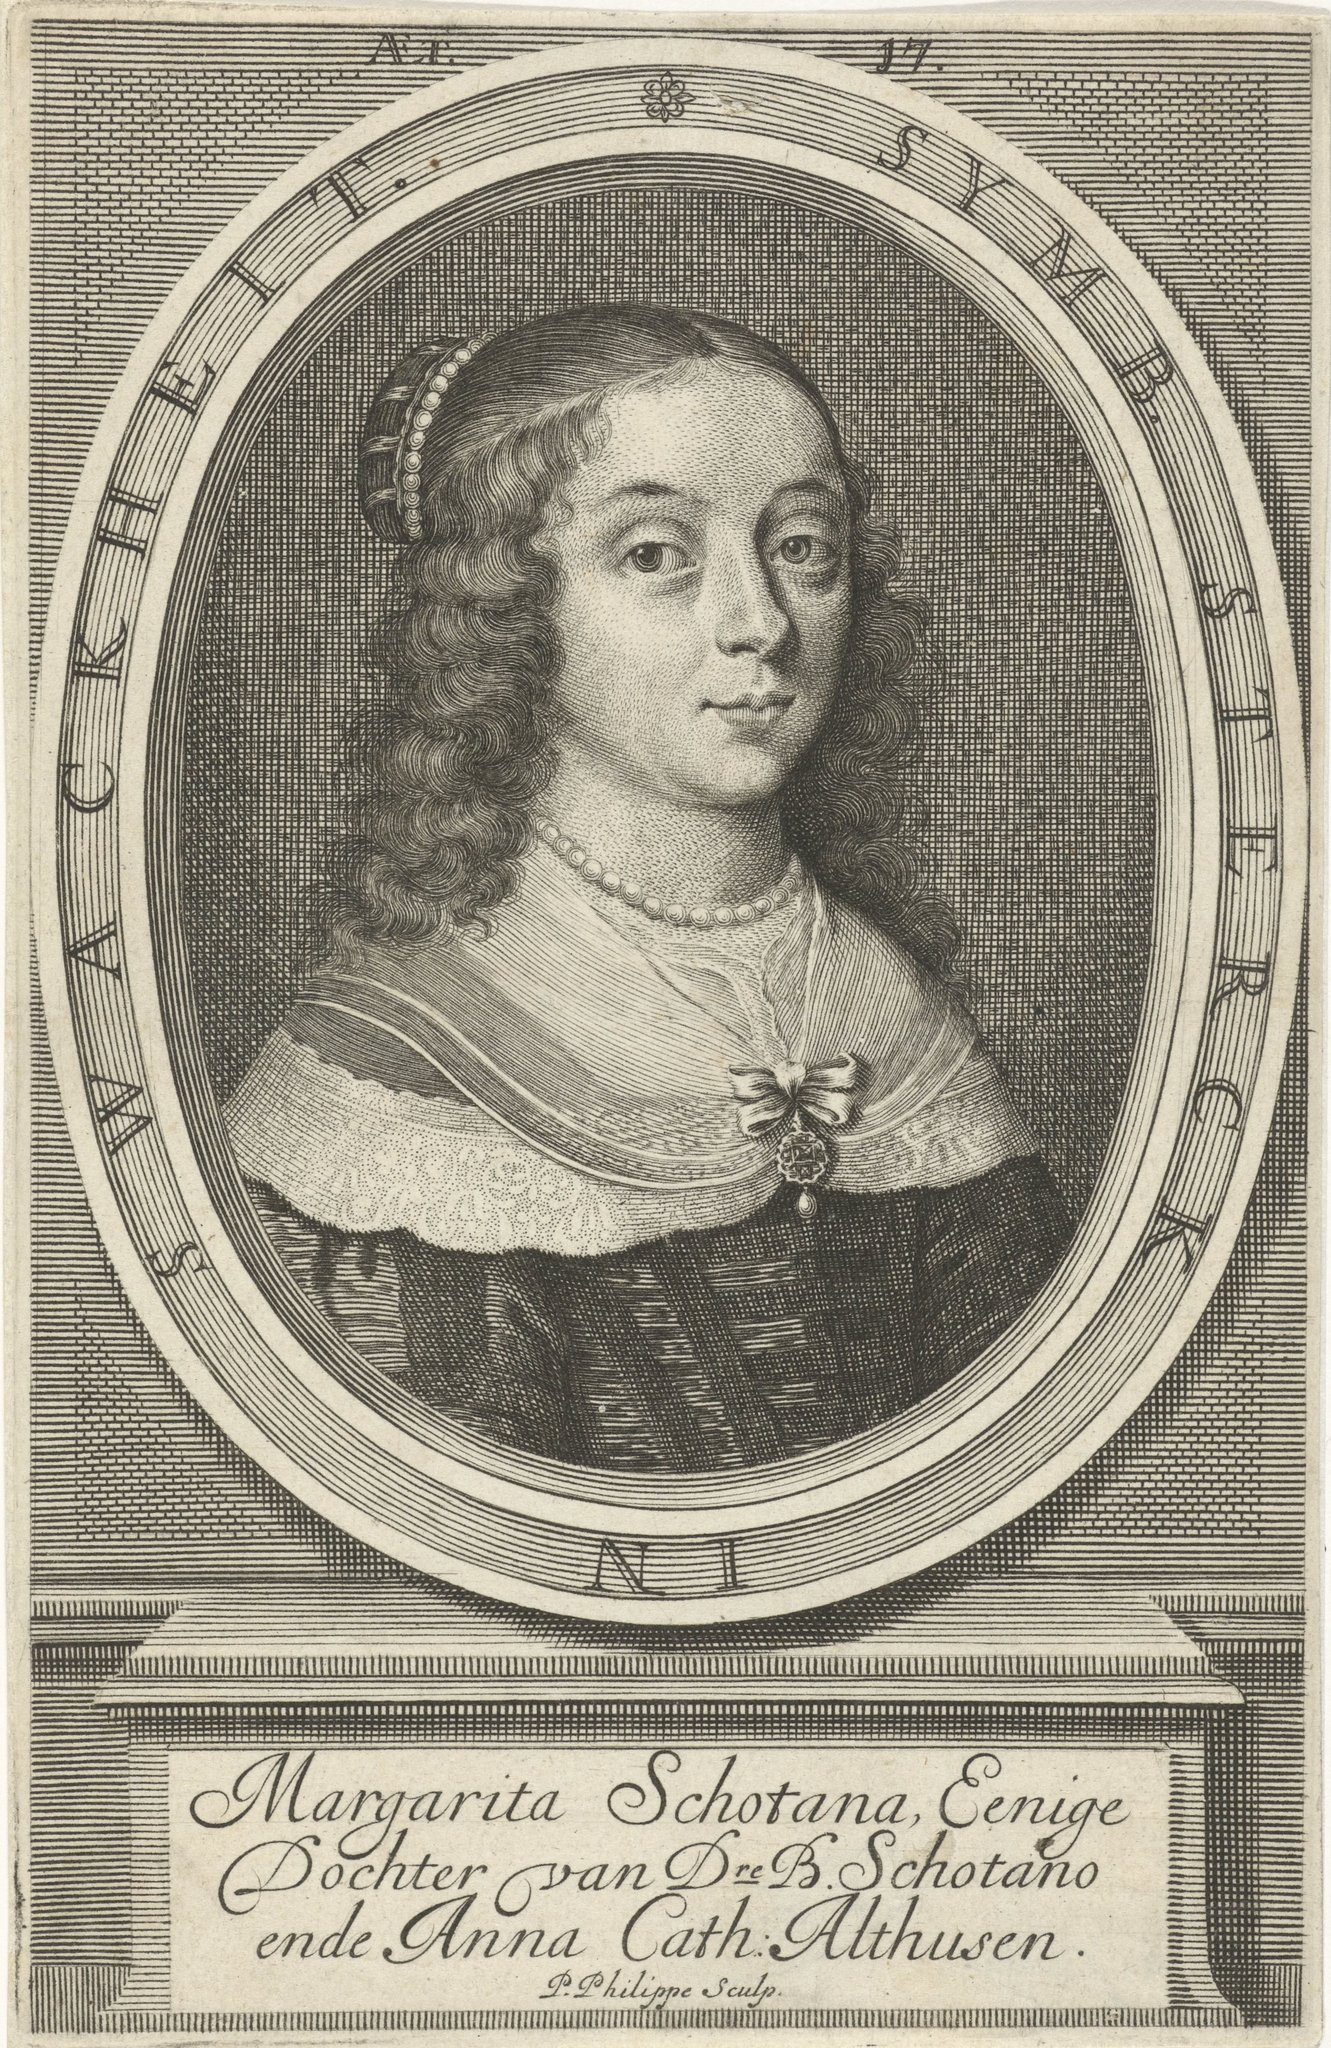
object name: print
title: Portret van Margarita Schotanus, op 17-jarige leeftijd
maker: pieter philippe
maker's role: print maker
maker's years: 1635-1702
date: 1635-1702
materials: paper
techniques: engraving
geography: the hague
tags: margarita schotanus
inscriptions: collector's mark: Lugt 2228